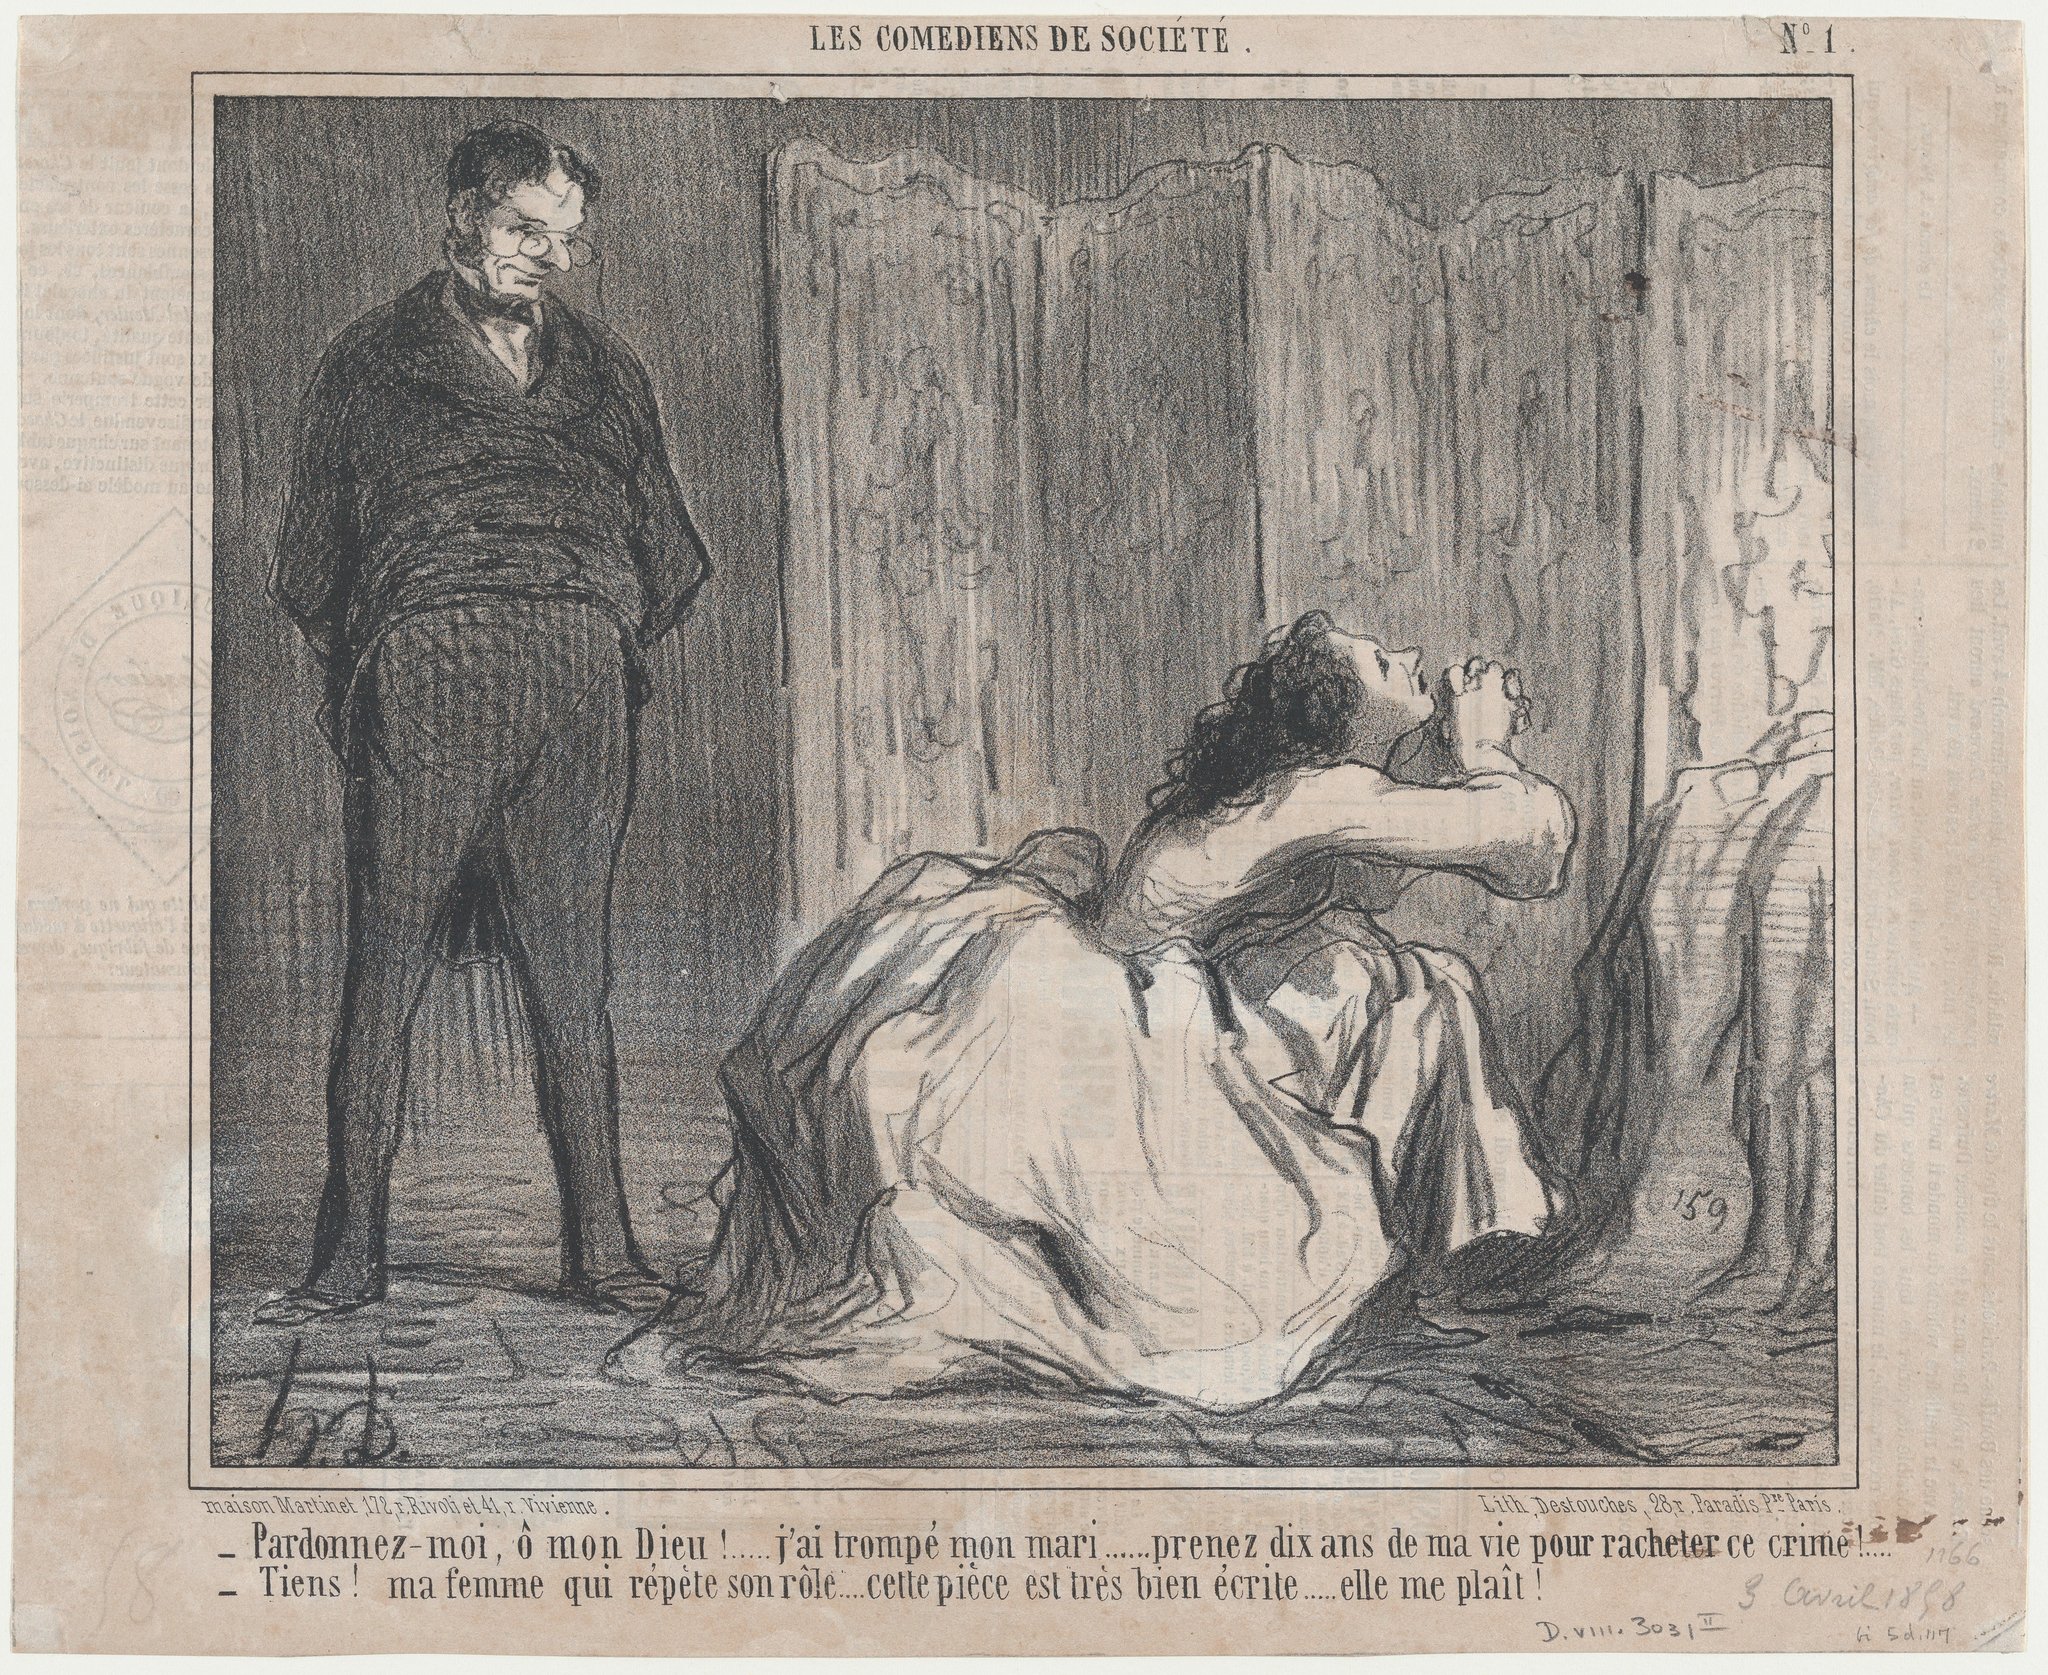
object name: print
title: Pardonnez-moi, ô mon Dieu!..., from Les Comédiens de Société, published in Le Charivari, April 3, 1858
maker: honoré daumier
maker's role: artist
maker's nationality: french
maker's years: 1808-1879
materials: paper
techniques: lithograph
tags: men,women